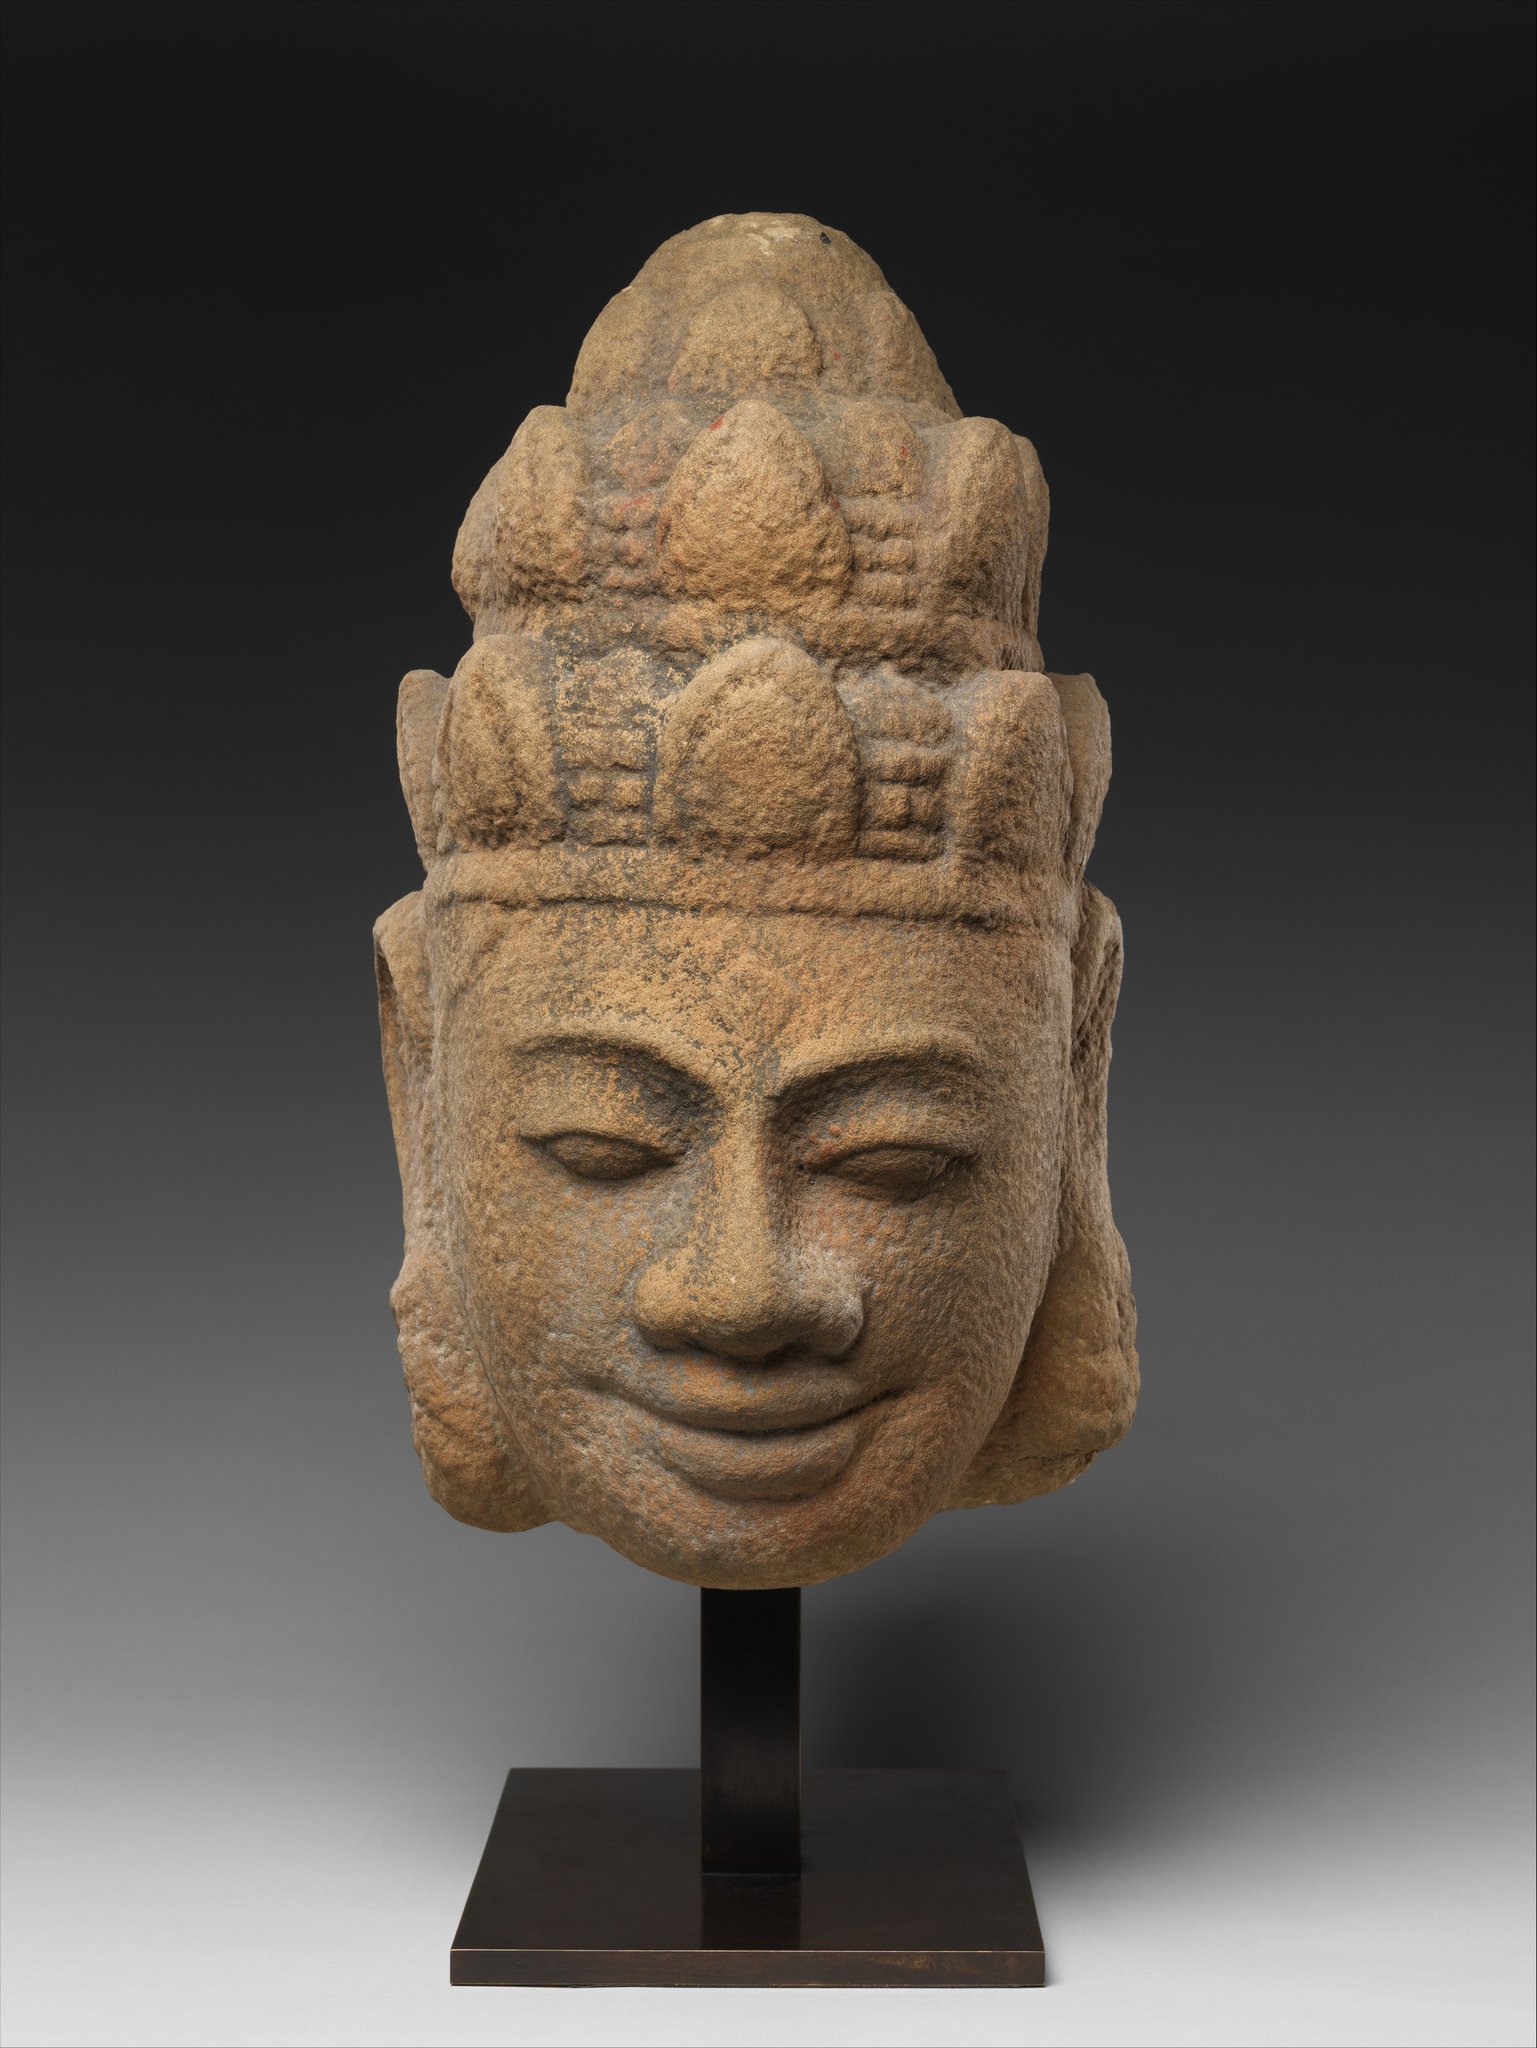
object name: head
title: Head of Shiva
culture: central vietnamese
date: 901-1000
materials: stone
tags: heads,shiva